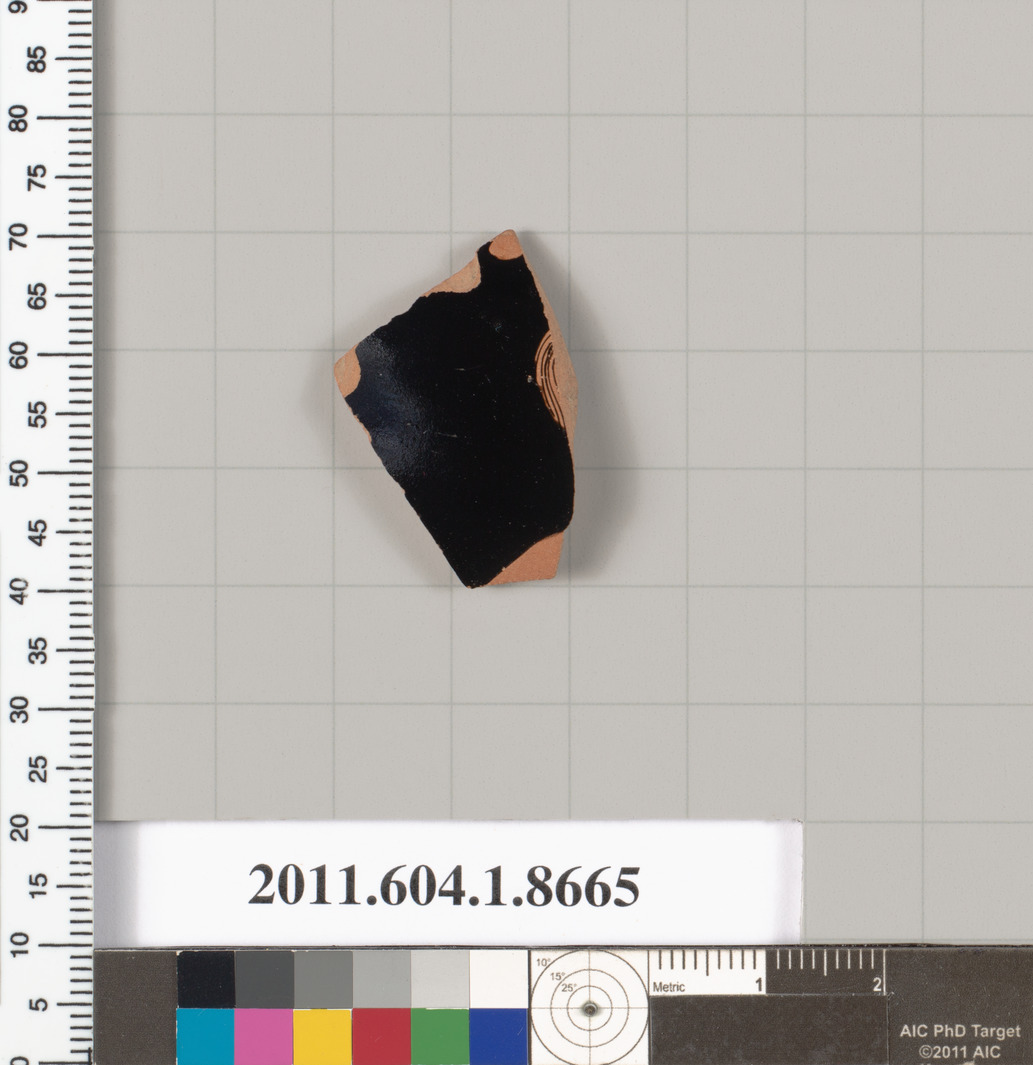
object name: kylix fragment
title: Terracotta rim fragment of a stemless? kylix (drinking cup)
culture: greek, attic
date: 475-451 BCE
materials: terracotta